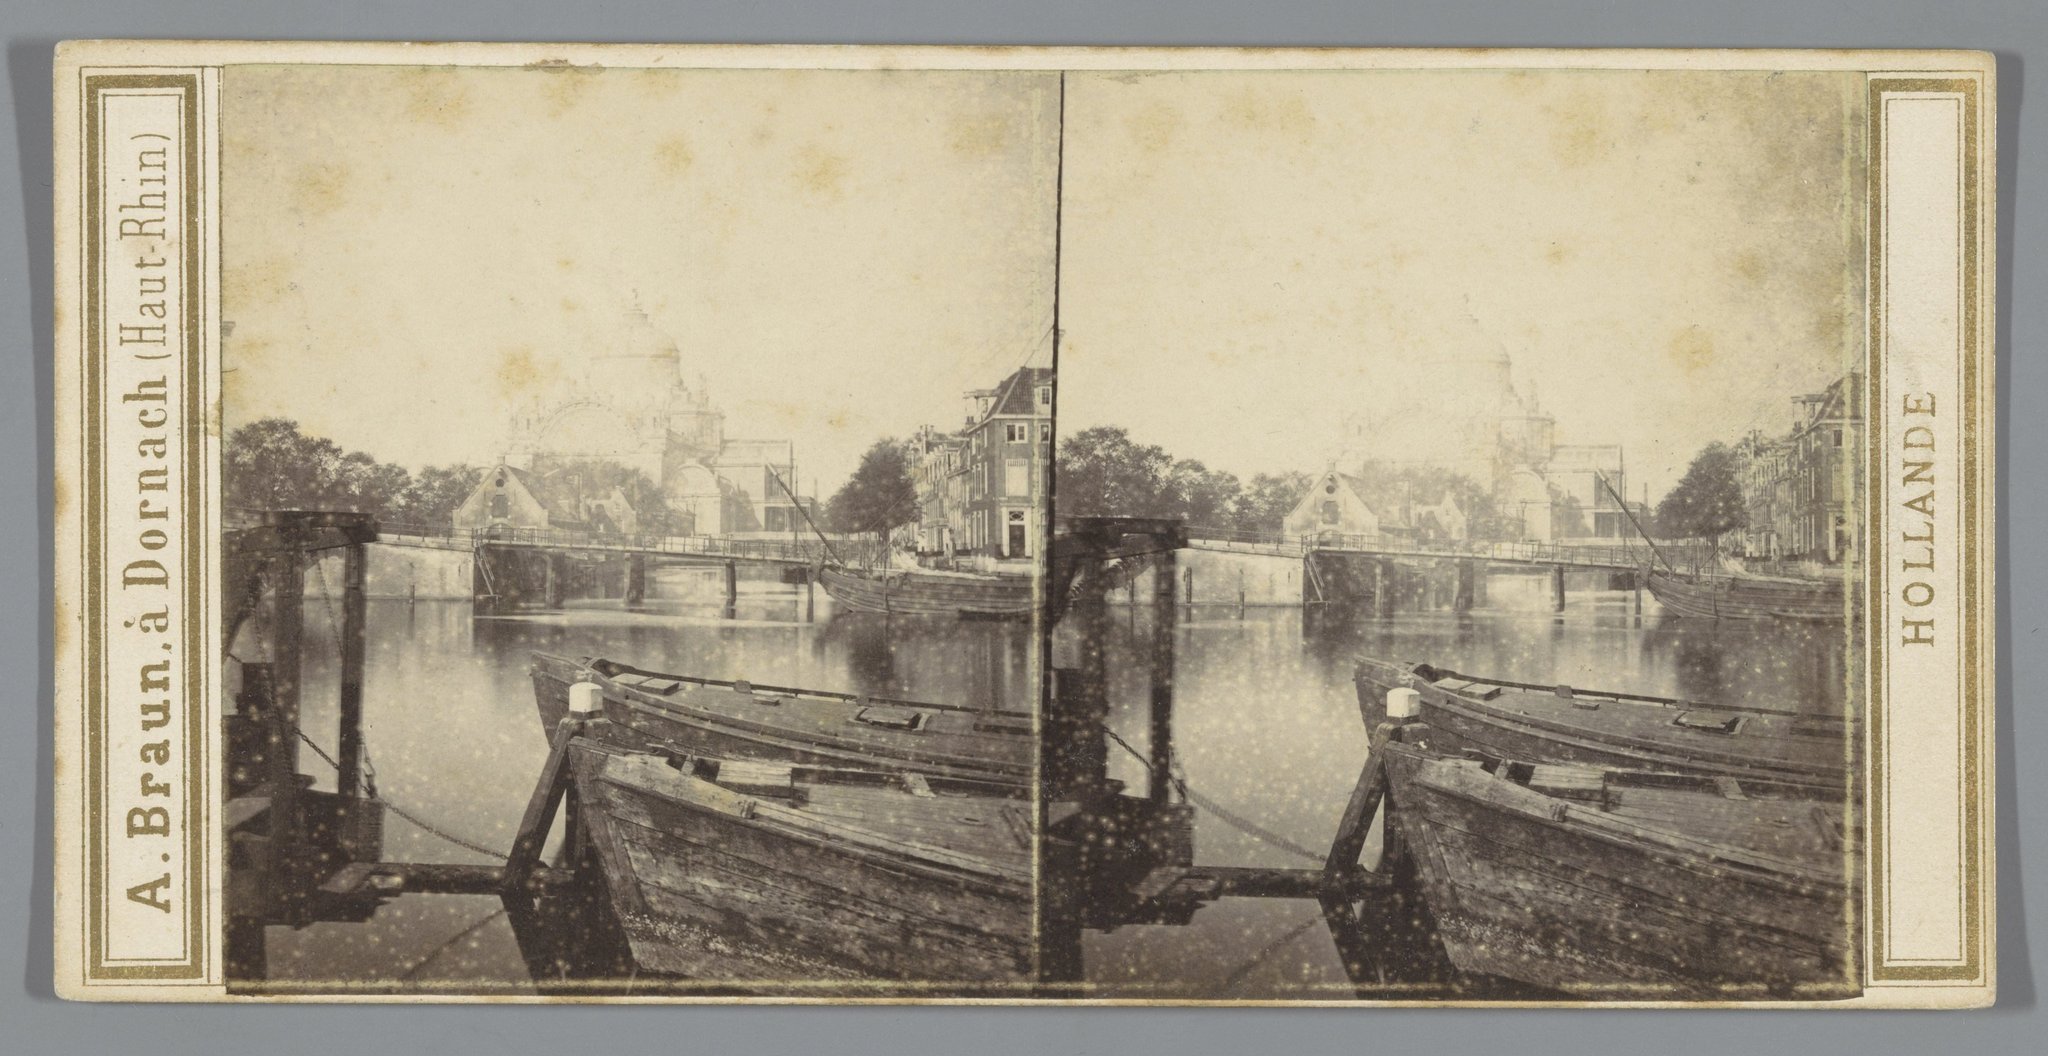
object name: stereograph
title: Hollande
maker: gaston braun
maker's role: fotograaf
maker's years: 1845-1928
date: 1864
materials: cardboard, paper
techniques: albumen print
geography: dornach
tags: palace, canals, waters (in city)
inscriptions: stamp: ‘S. A. MEERBURG/ LEIJDEN’, number: ‘No. 3990.’, name: ‘J. C. MEERBURG,’